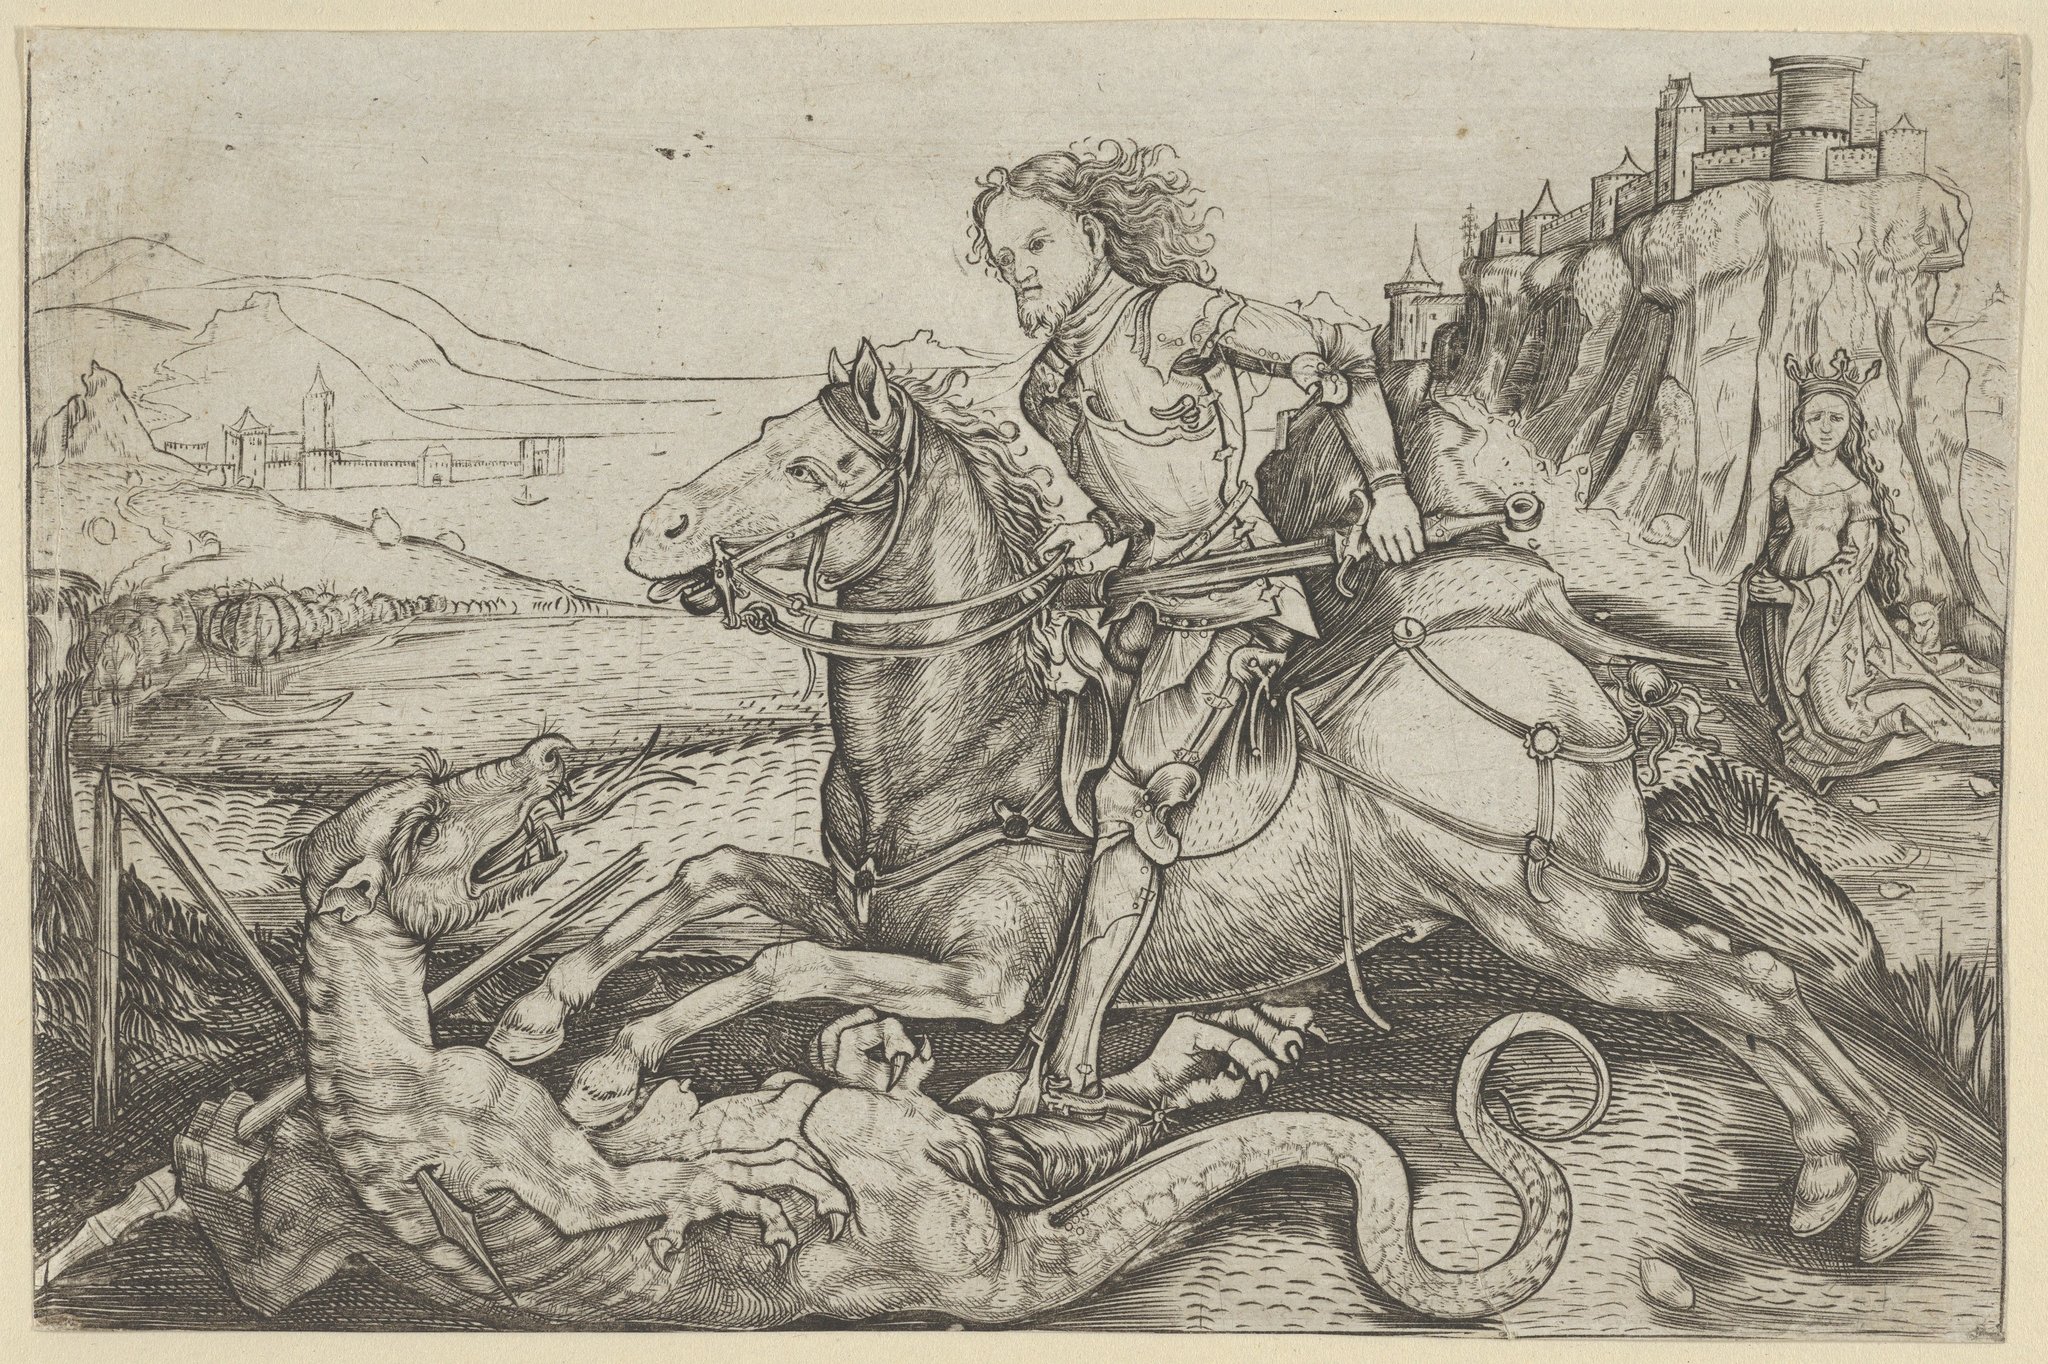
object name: print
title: St. George and the Dragon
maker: master ag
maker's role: artist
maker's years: 1475-1510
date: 1480-1490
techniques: engraving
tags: dragons,horses,saint george